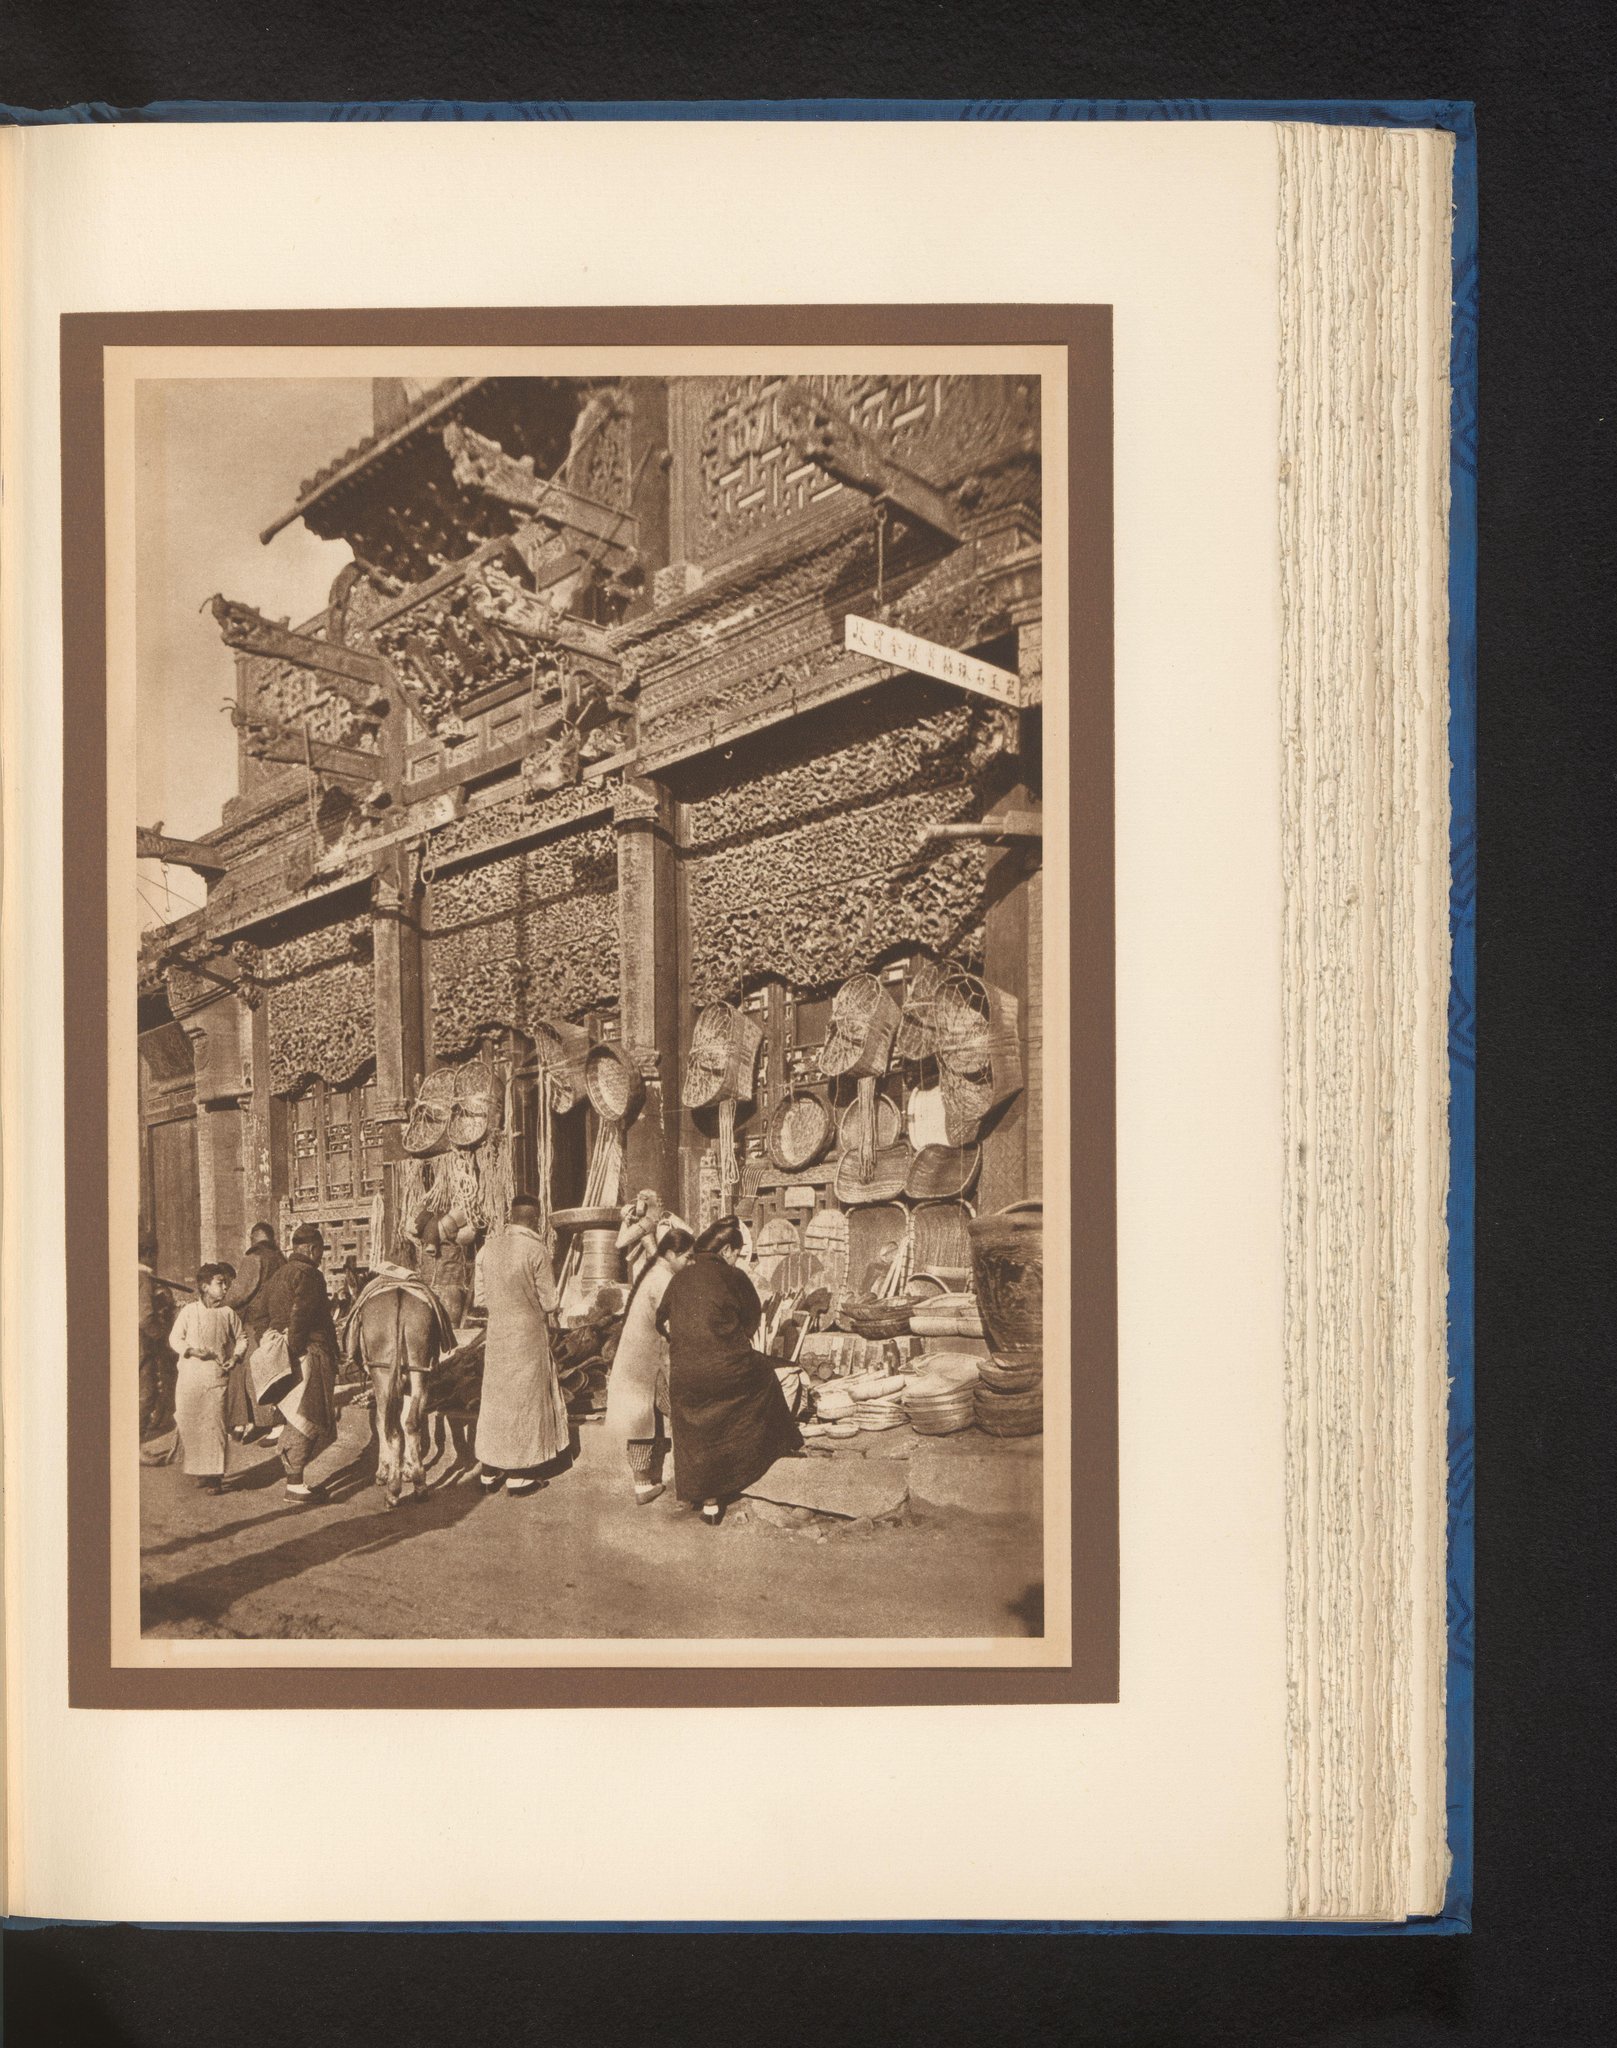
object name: photomechanical print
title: Onbekende personen bij een winkel te Peking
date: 1915-1920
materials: paper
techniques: rotogravure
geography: beijing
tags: shop, store, historical persons